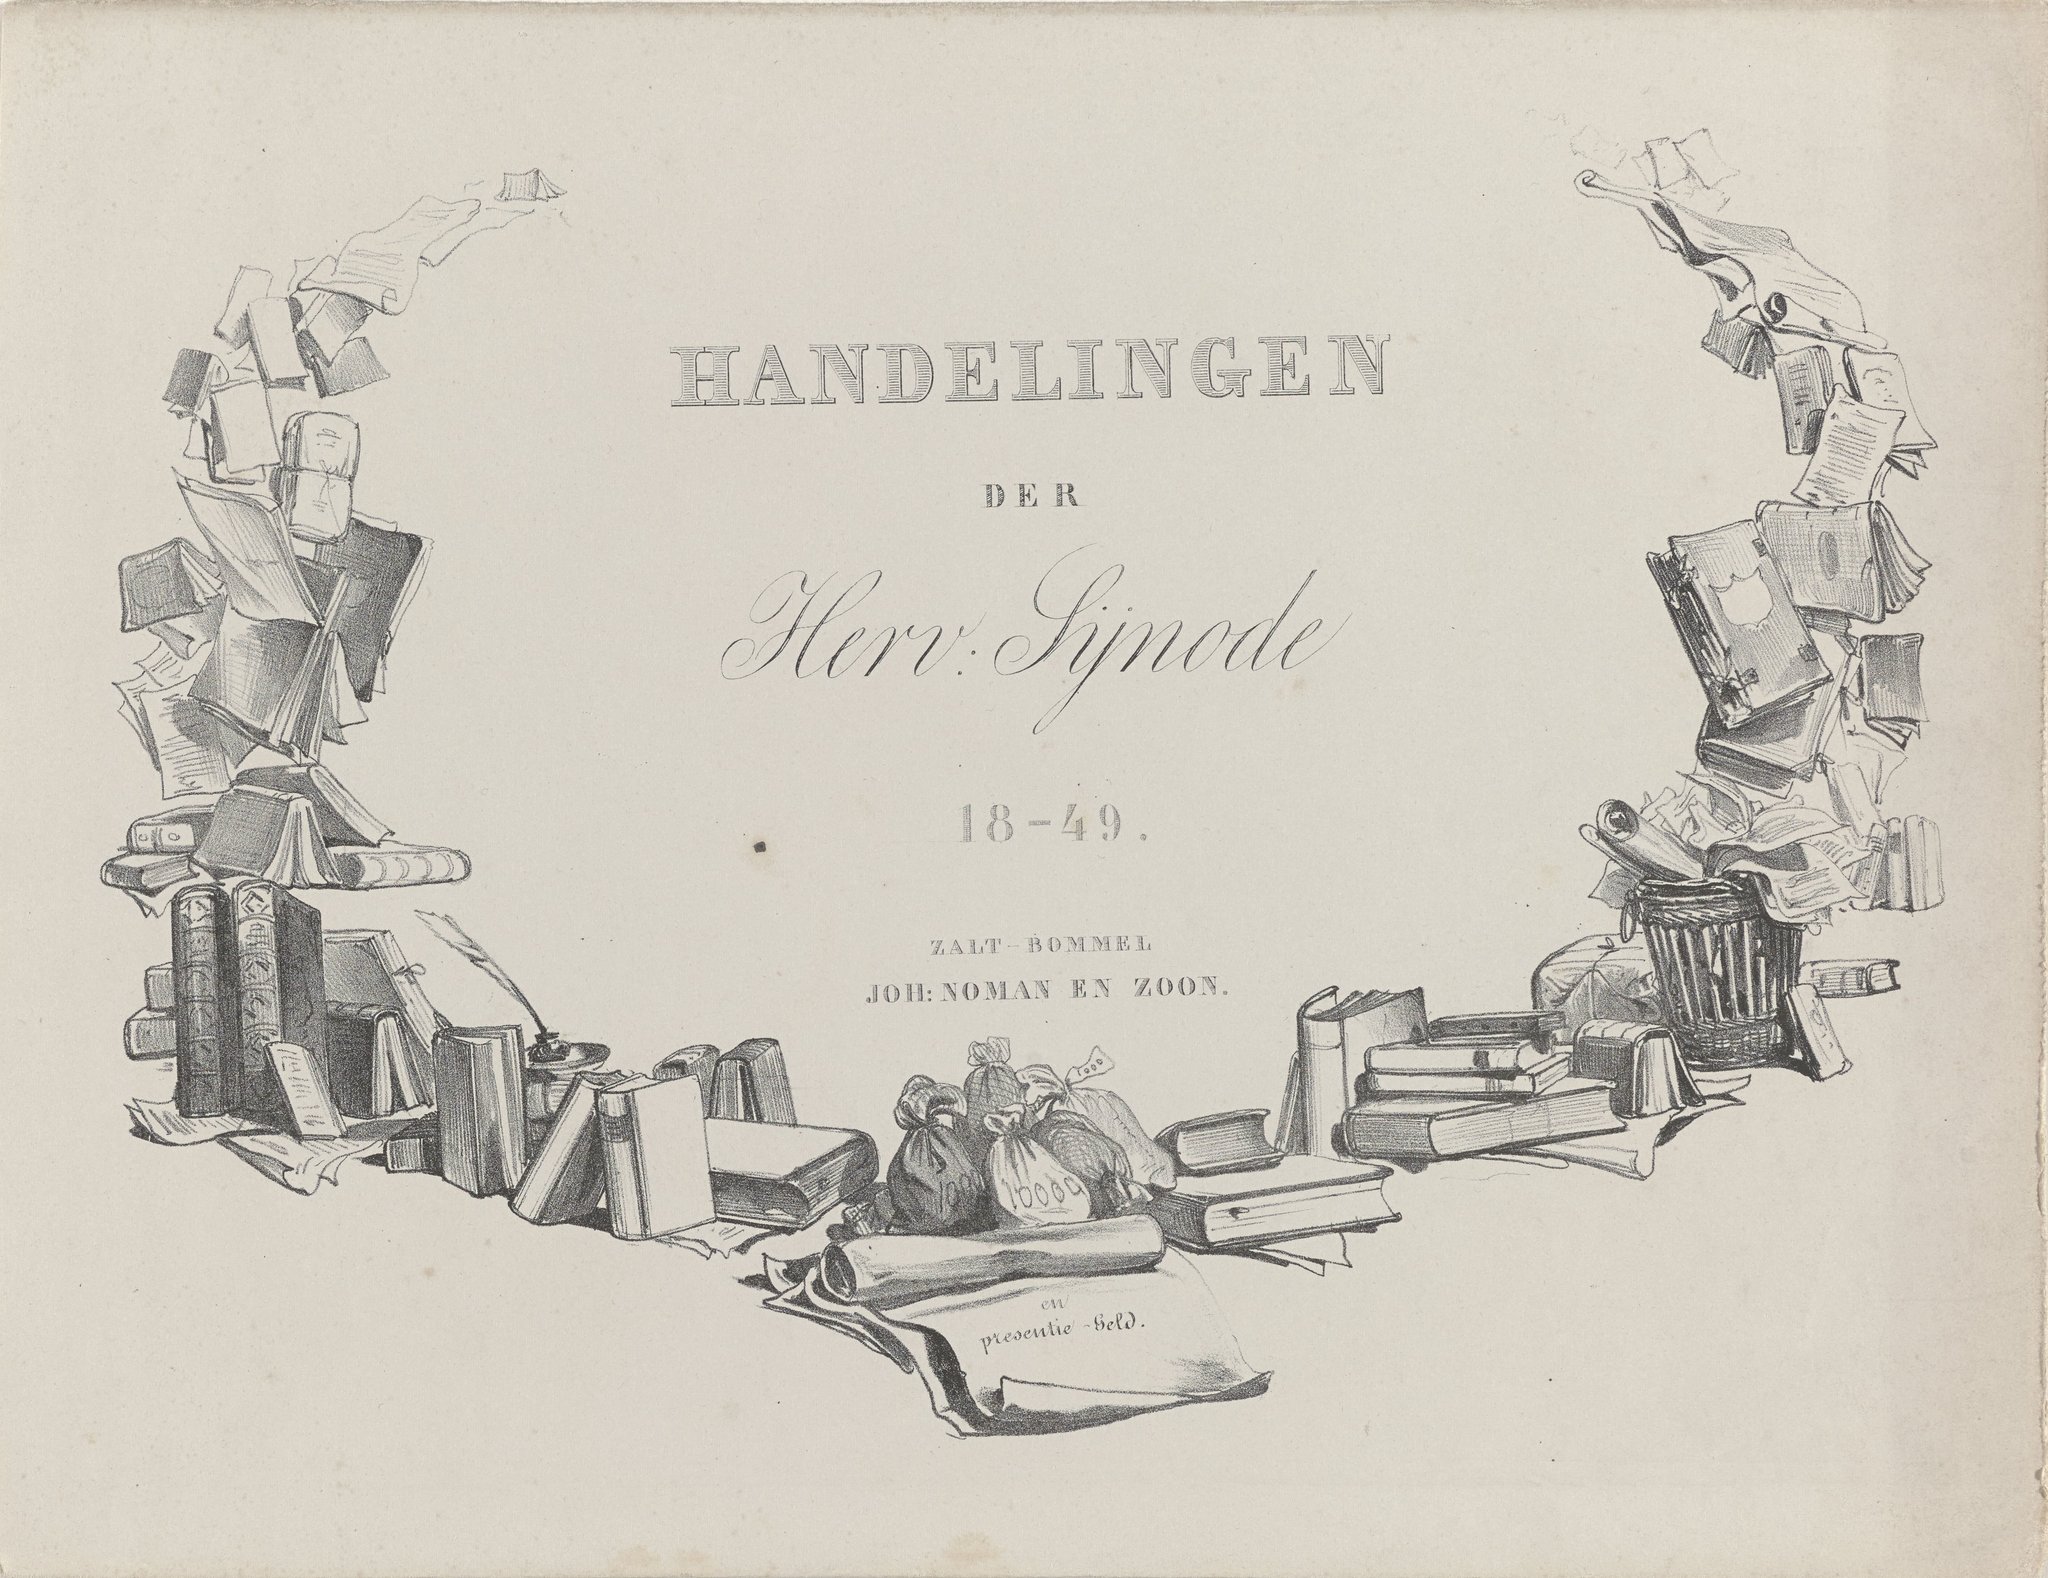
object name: print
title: Handelingen der Herv: Sijnode 1849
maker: Anonymous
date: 1849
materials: paper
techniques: lithograph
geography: netherlands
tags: organizations, assemblies, etc. in protestant churches, book, amsterdam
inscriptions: collector's mark: Lugt 2228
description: Titelprent met de titel binnen een krans van boeken, paperassen en zakken met geld met opschrift 'presentie-geld'. Losse prent in de omslag met drie spotprenten en een tekstblad over de vergadering van de Algemene Synode van de Hervormde Kerk te Amsterdam op 4 juli 1849.